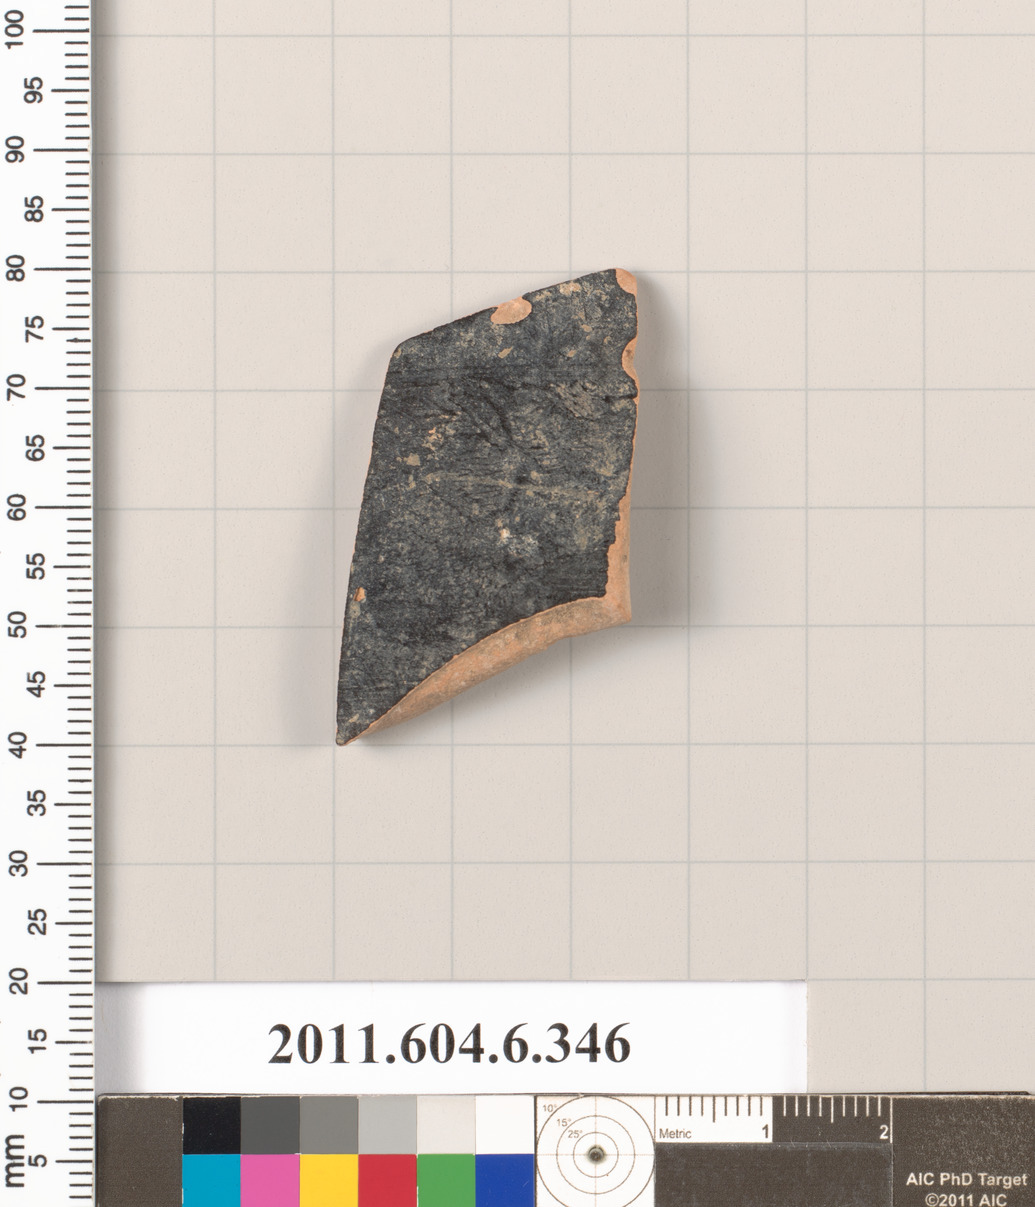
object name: undetermined closed shape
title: Terracotta fragment of a closed shape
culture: greek, attic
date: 600-401 BCE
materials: terracotta